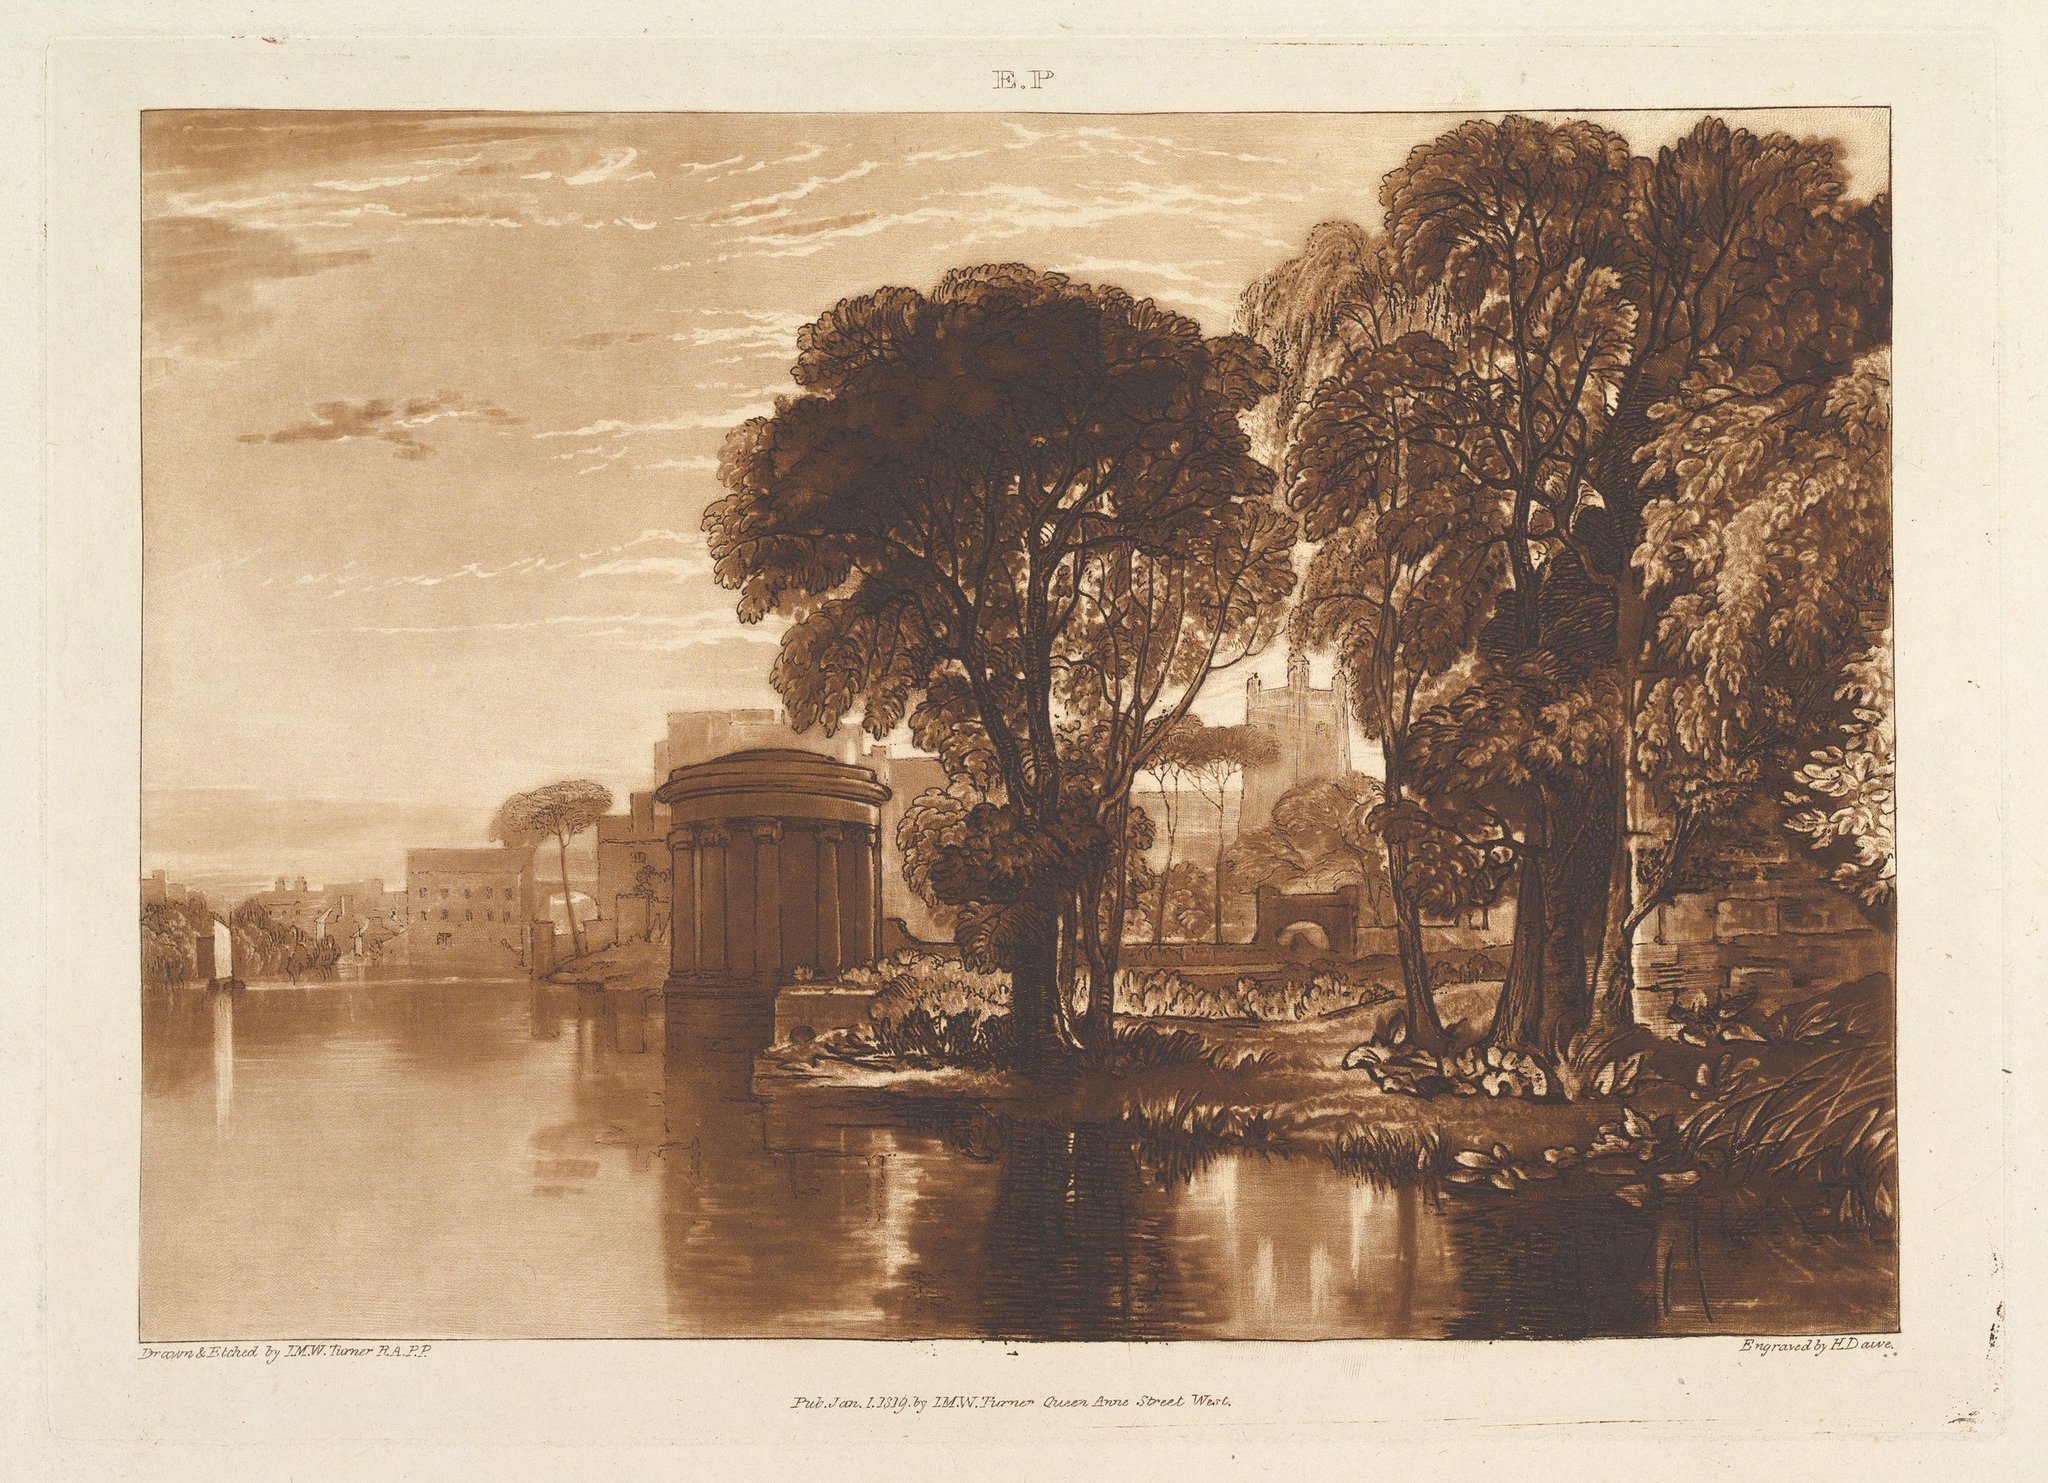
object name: print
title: The Alcove, Isleworth, part XIII, plate 63 from "Liber Studiorum"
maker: joseph mallord william turner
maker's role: artist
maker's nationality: british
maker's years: 1775-1851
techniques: etching, mezzotint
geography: london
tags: rivers,landscapes